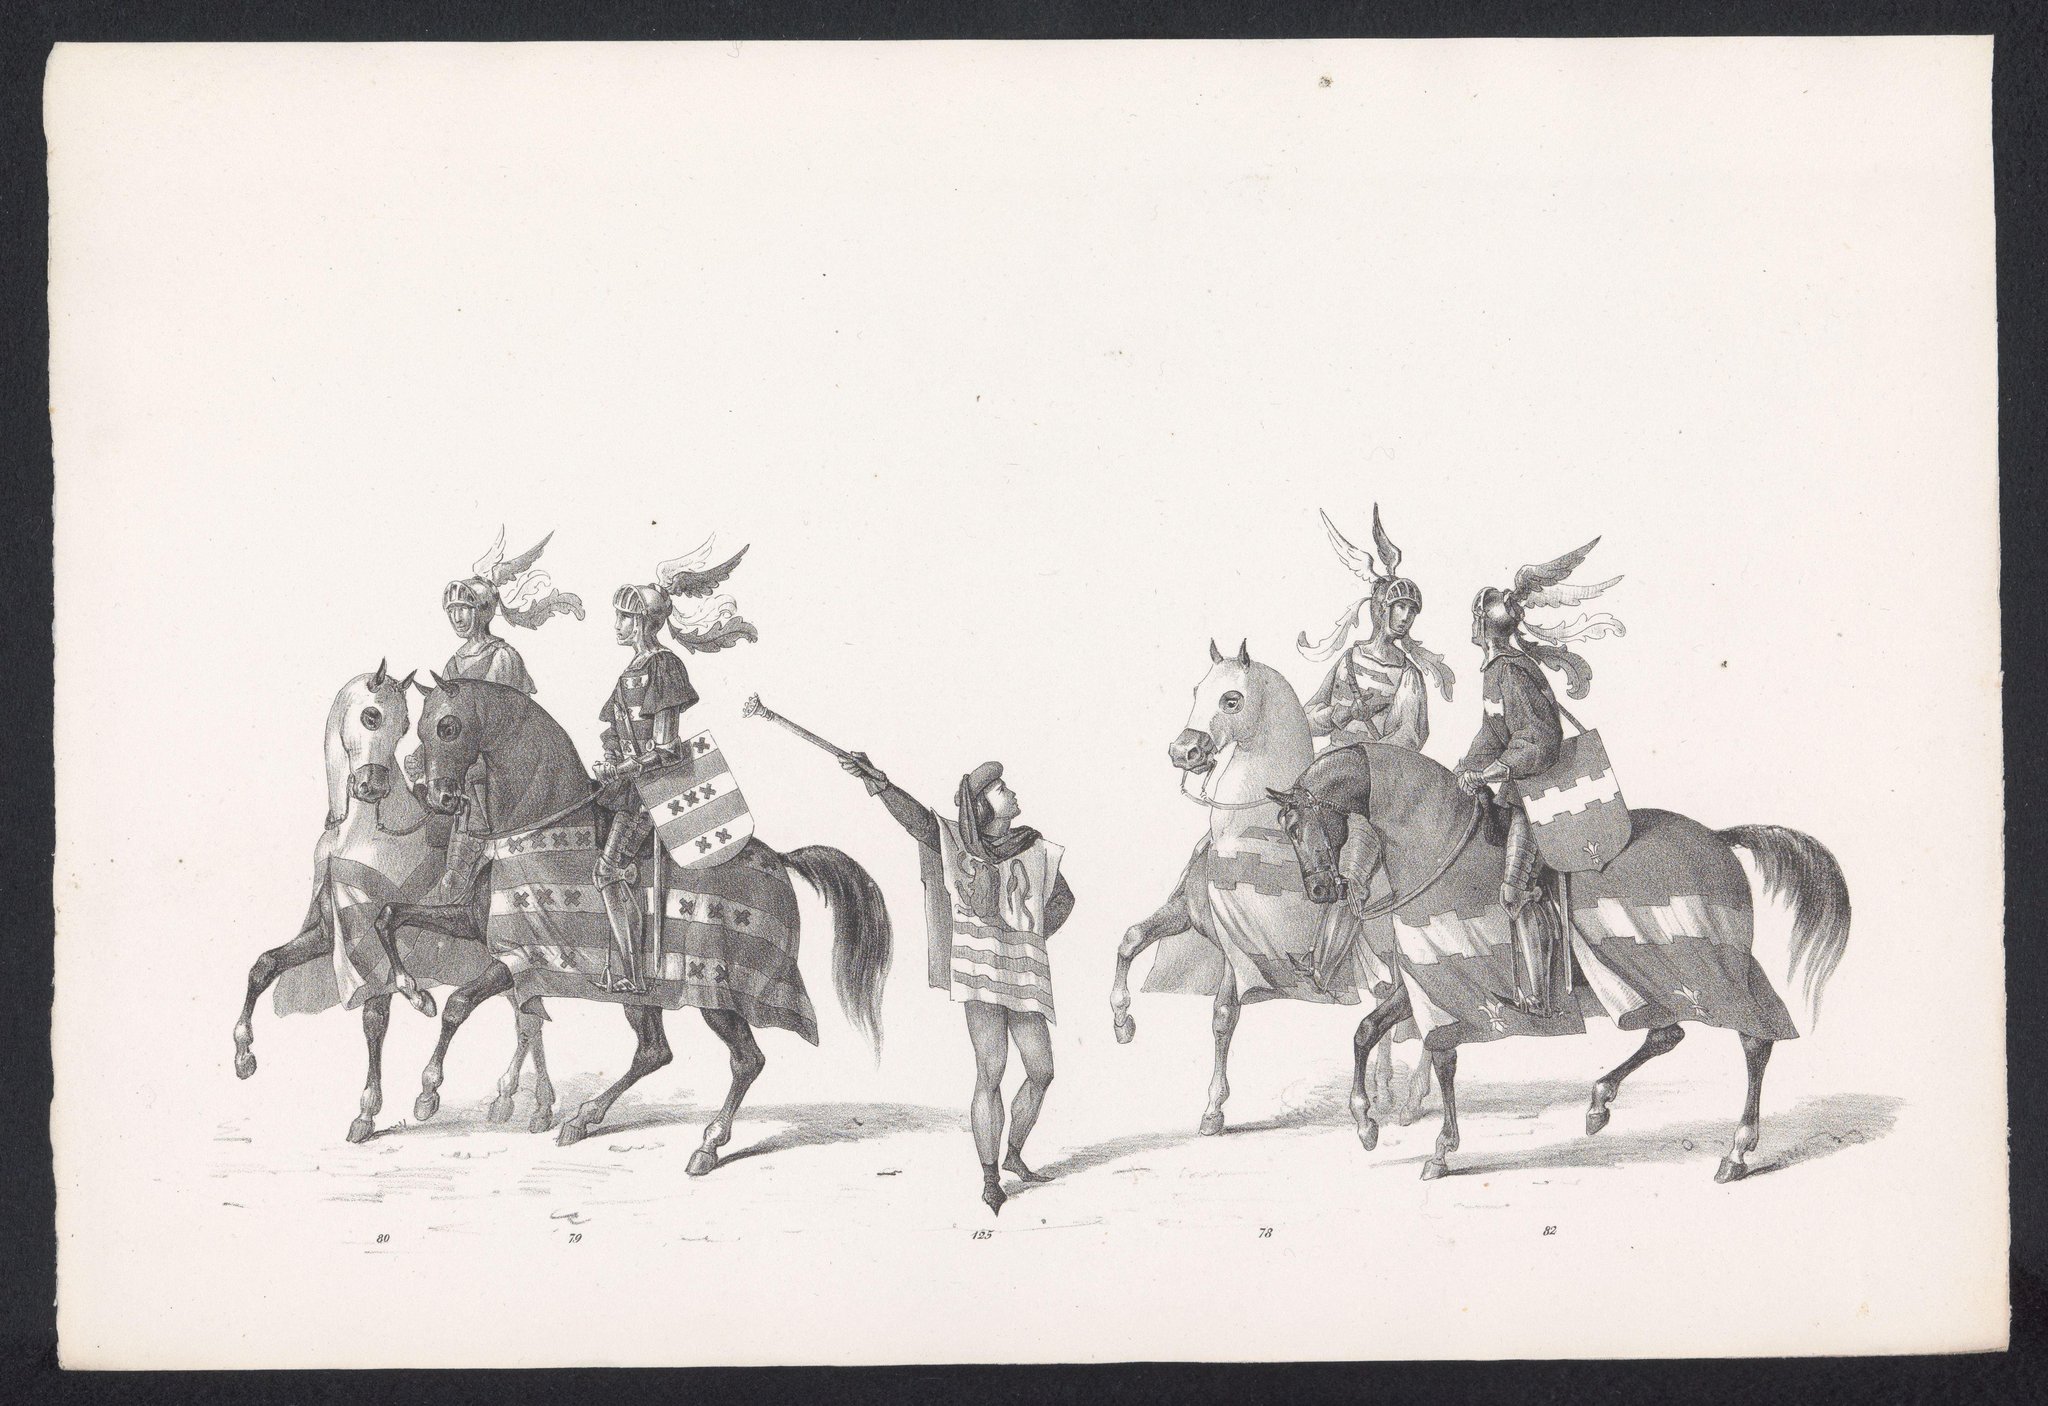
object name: print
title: Maskerade door studenten van de Leidse Hogeschool, 1840 (plaat 12)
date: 1840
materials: paper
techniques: lithograph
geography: leiden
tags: jan van beieren, students' pageant, costumes used in pageants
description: Historische gekostumeerde optocht van de studenten van de Hogeschool van Leiden op 8 februari 1840. De optocht verbeeldt de intocht van hertog Jan van Beieren te Leiden op 18 augustus 1420. Twaalfde plaat in een serie van negentien ongenummerde platen, met de groepen genummerd 78-82.